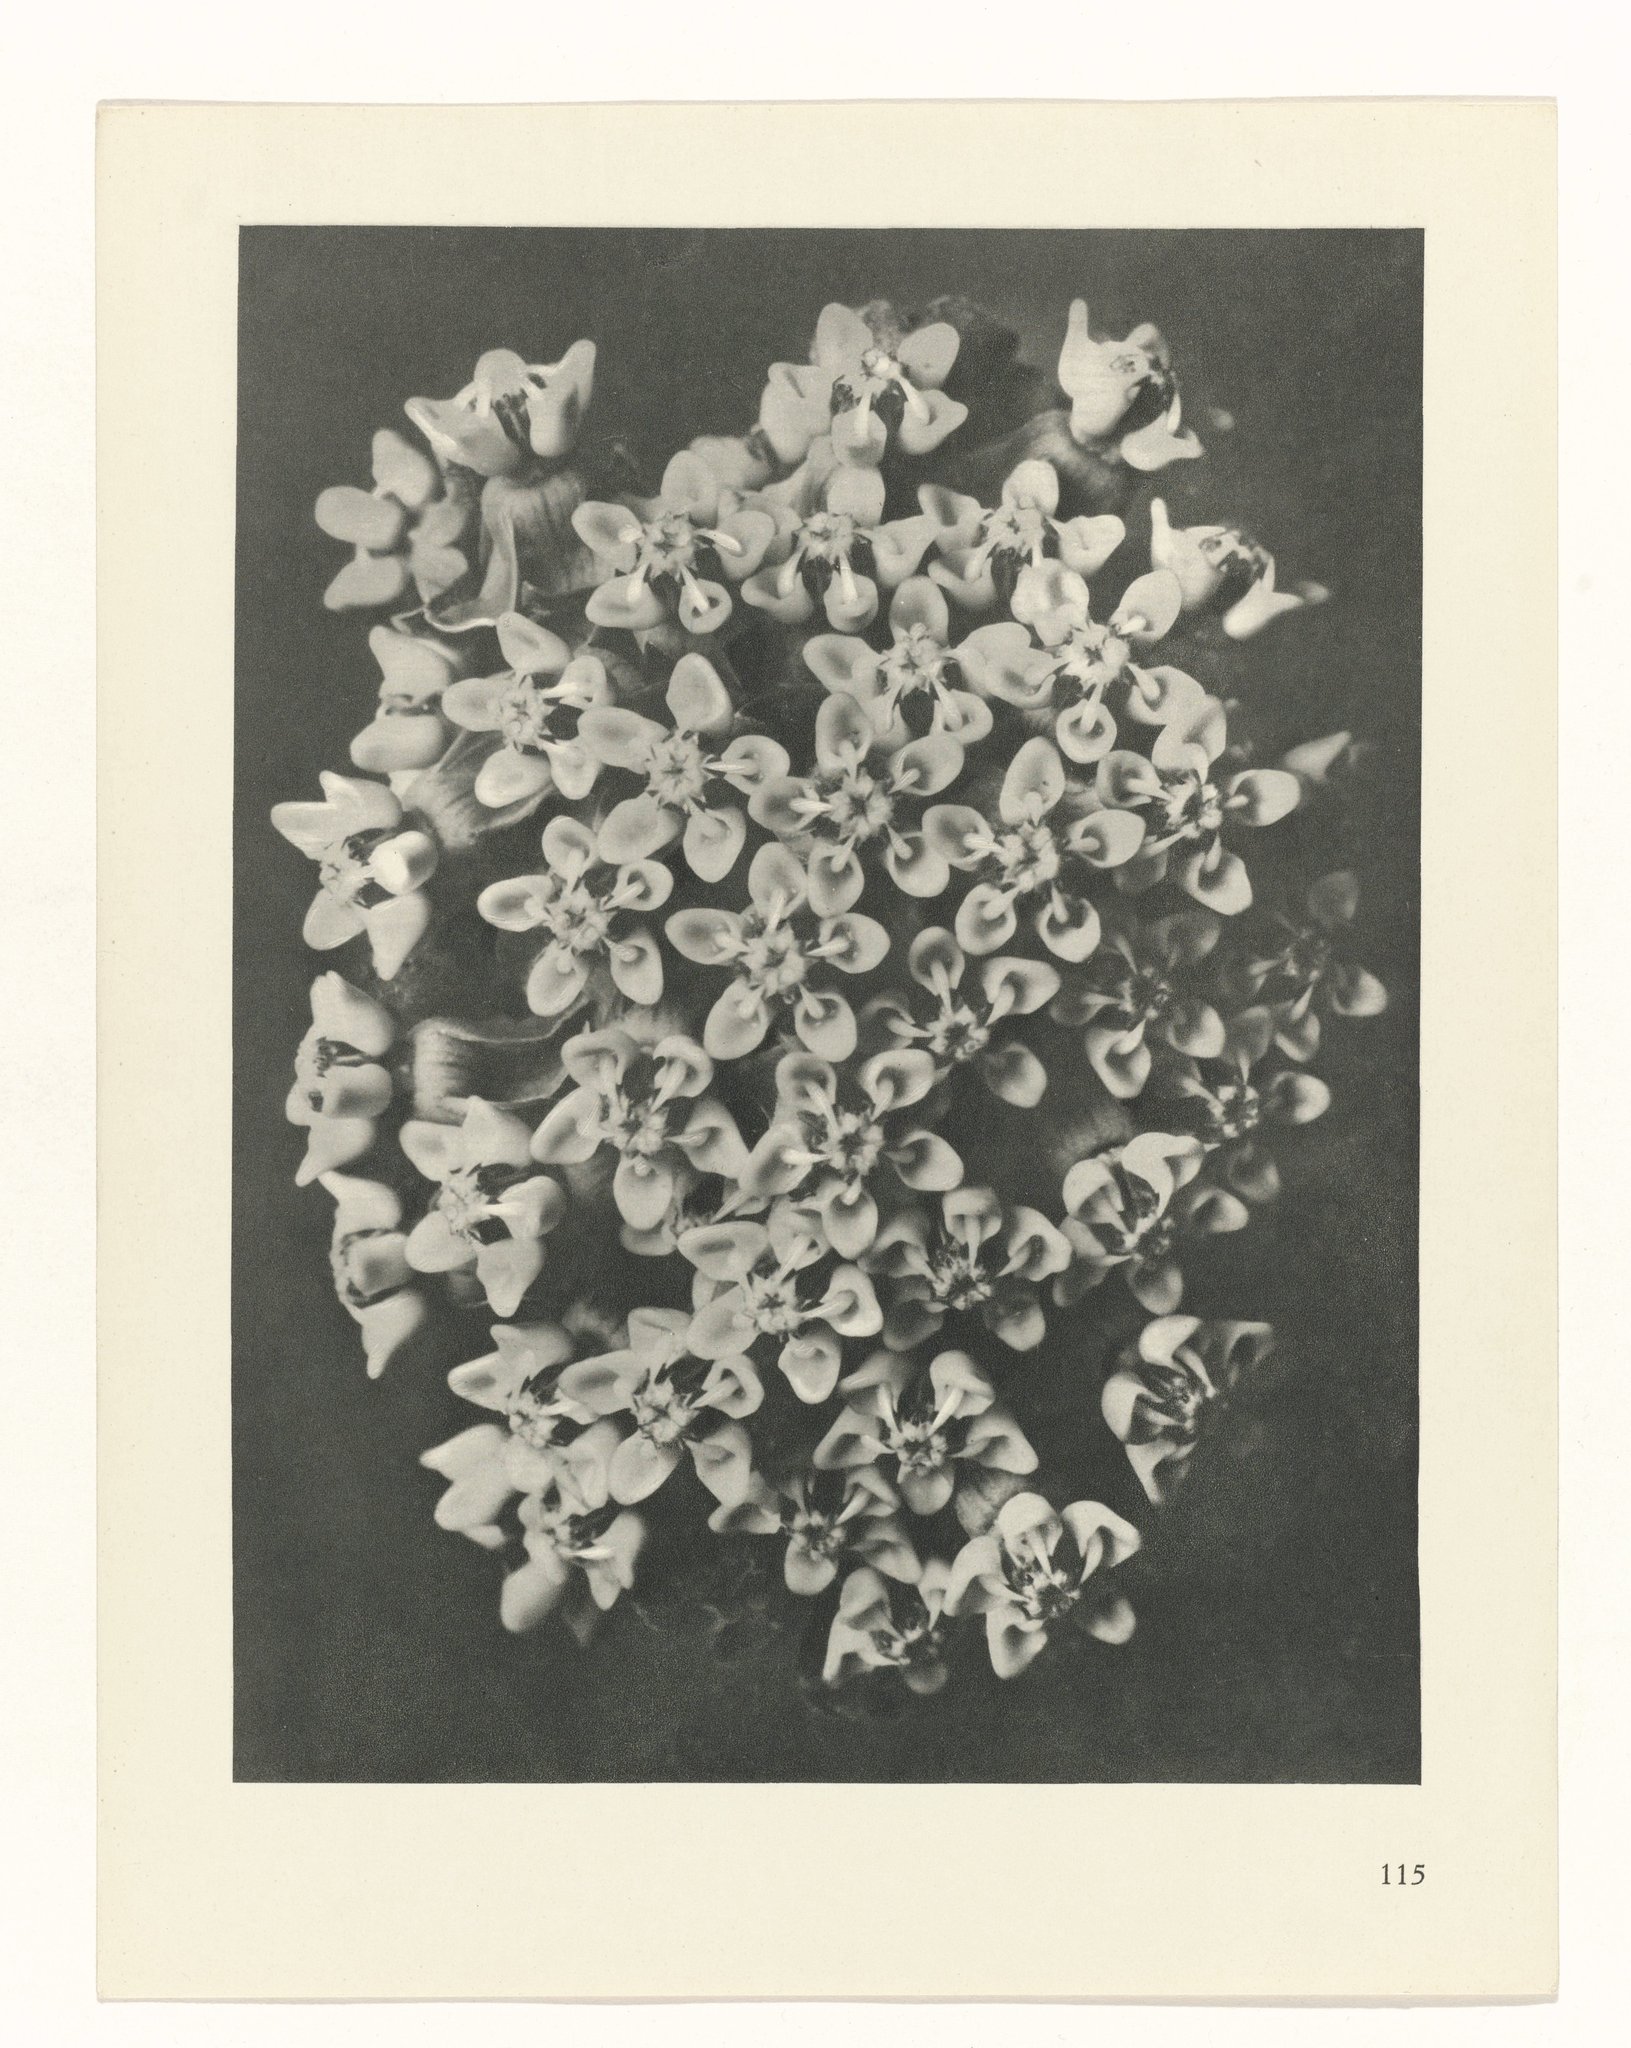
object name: photograph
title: Plantstudie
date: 1928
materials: ink, paper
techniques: rotogravure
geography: berlin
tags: plants (in general)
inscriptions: number: ‘115’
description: facher Vergrößerung. Afkomstig uit losbladige uitgave.